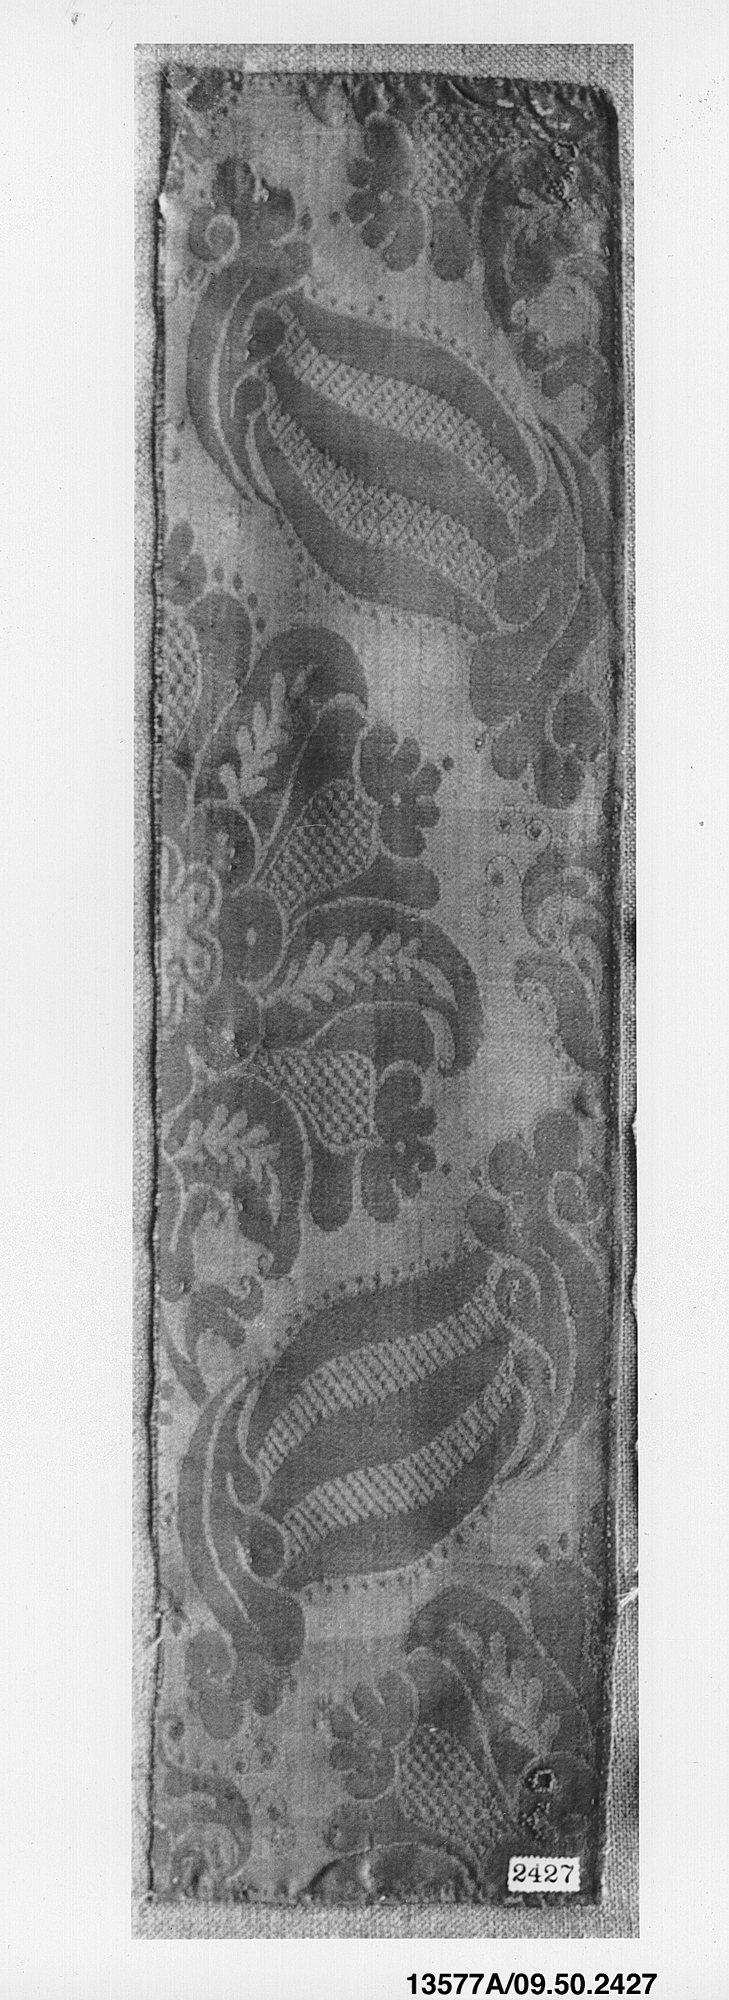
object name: piece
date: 1701-1733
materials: silk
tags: leaves